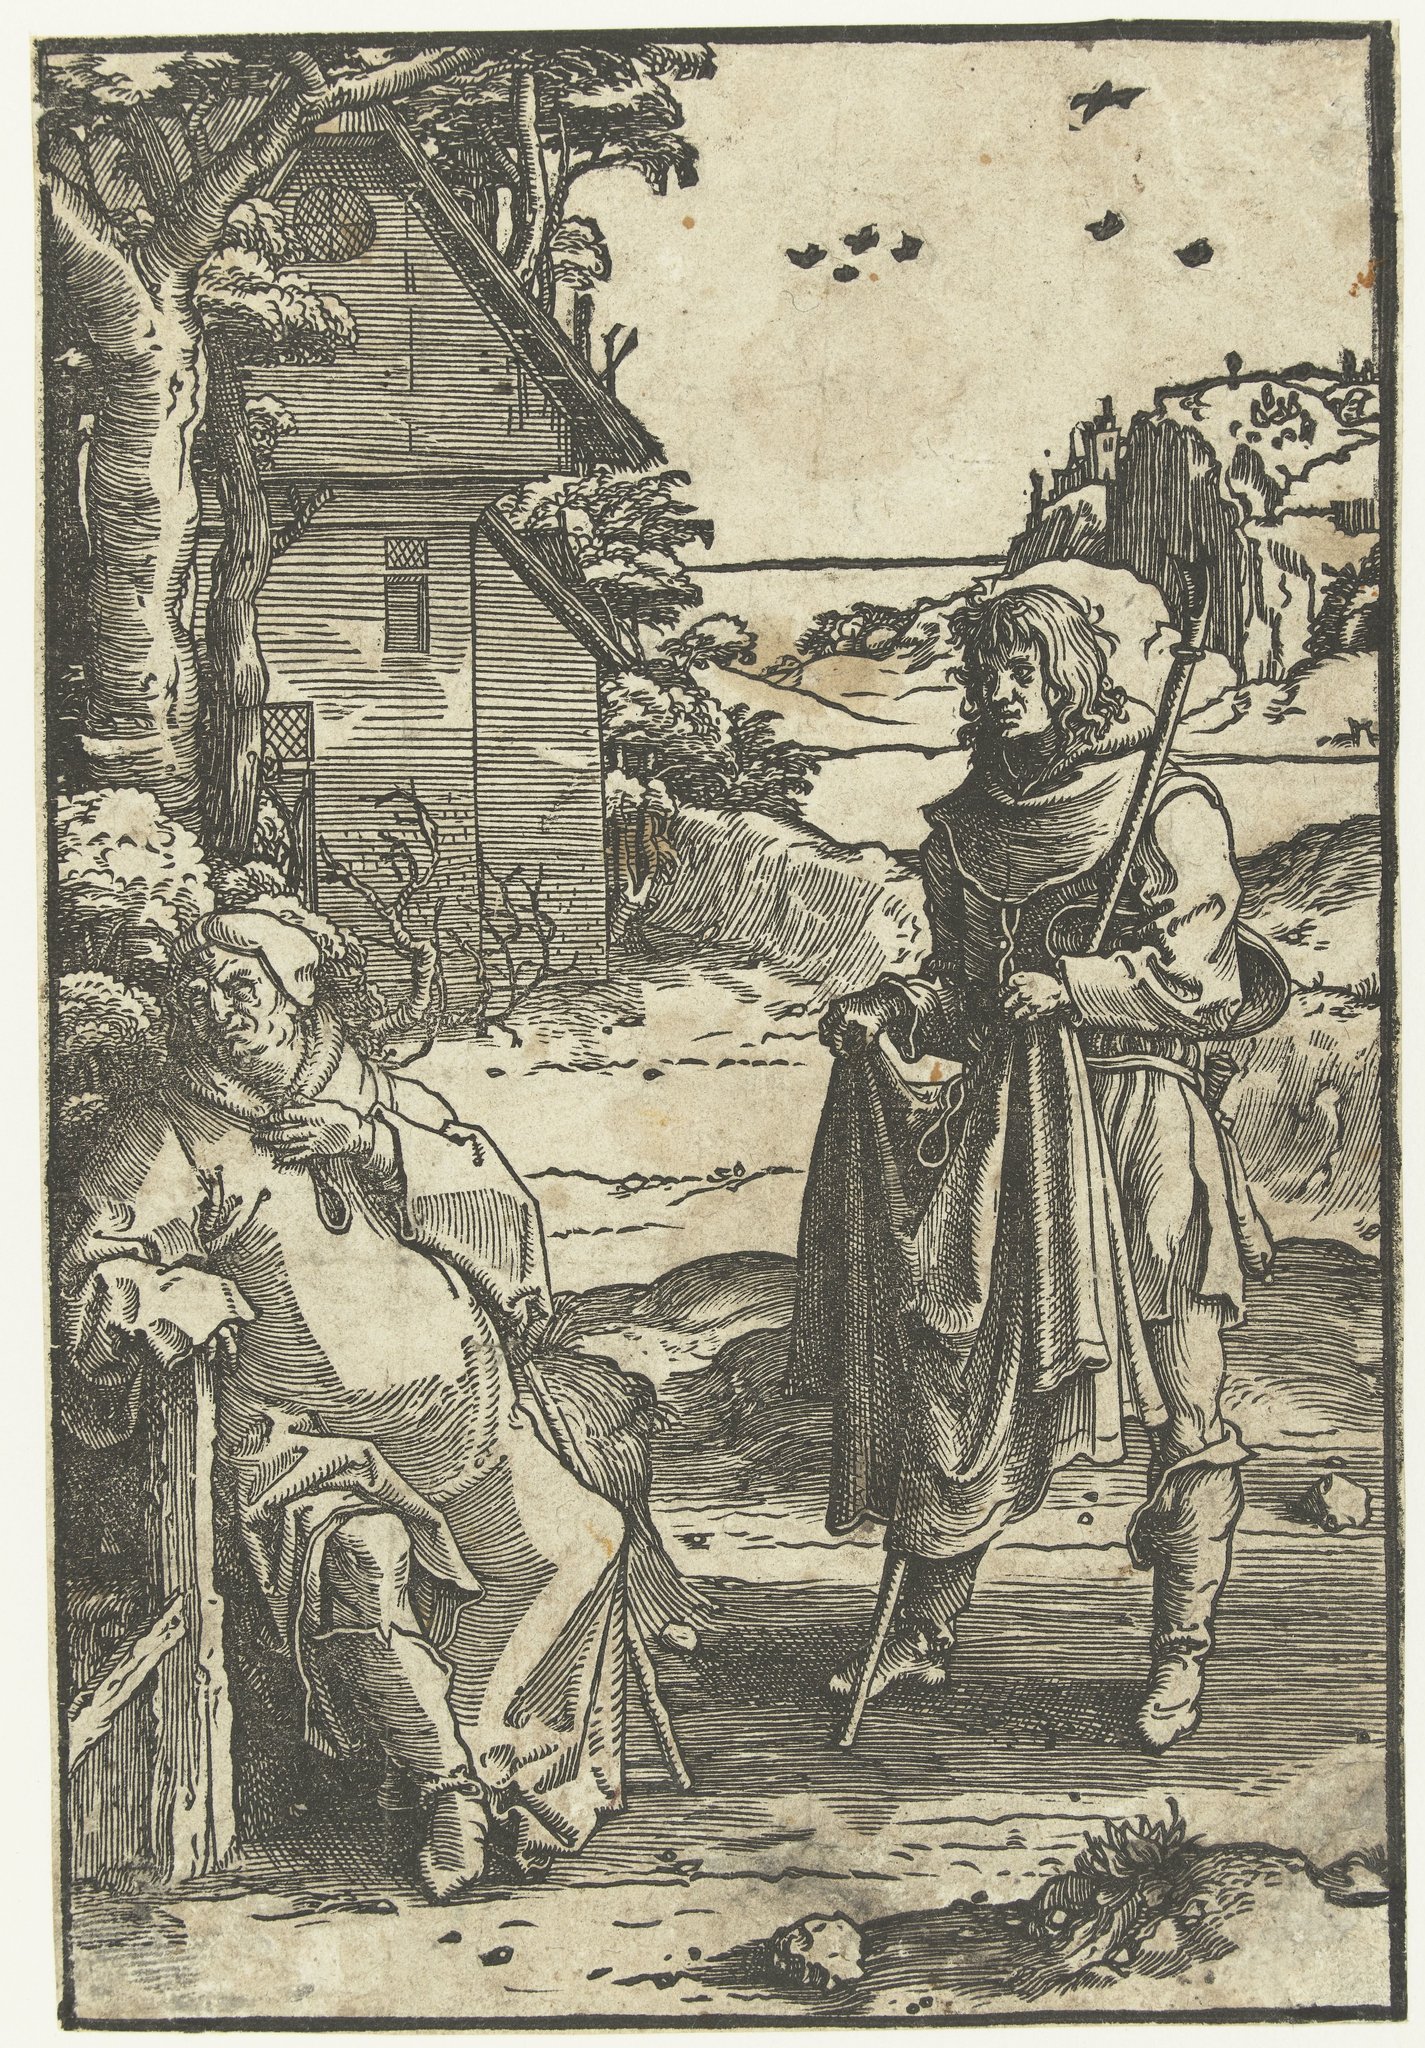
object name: print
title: Het bloederige kleed van Jozef aan Jacob getoond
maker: lucas van leyden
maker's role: draughtsman, painter, print maker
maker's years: 1494-1533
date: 1515-1519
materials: paper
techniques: woodcut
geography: low countries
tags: joseph's blood-stained coat is brought and shown to jacob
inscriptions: collector's mark: Lugt 240